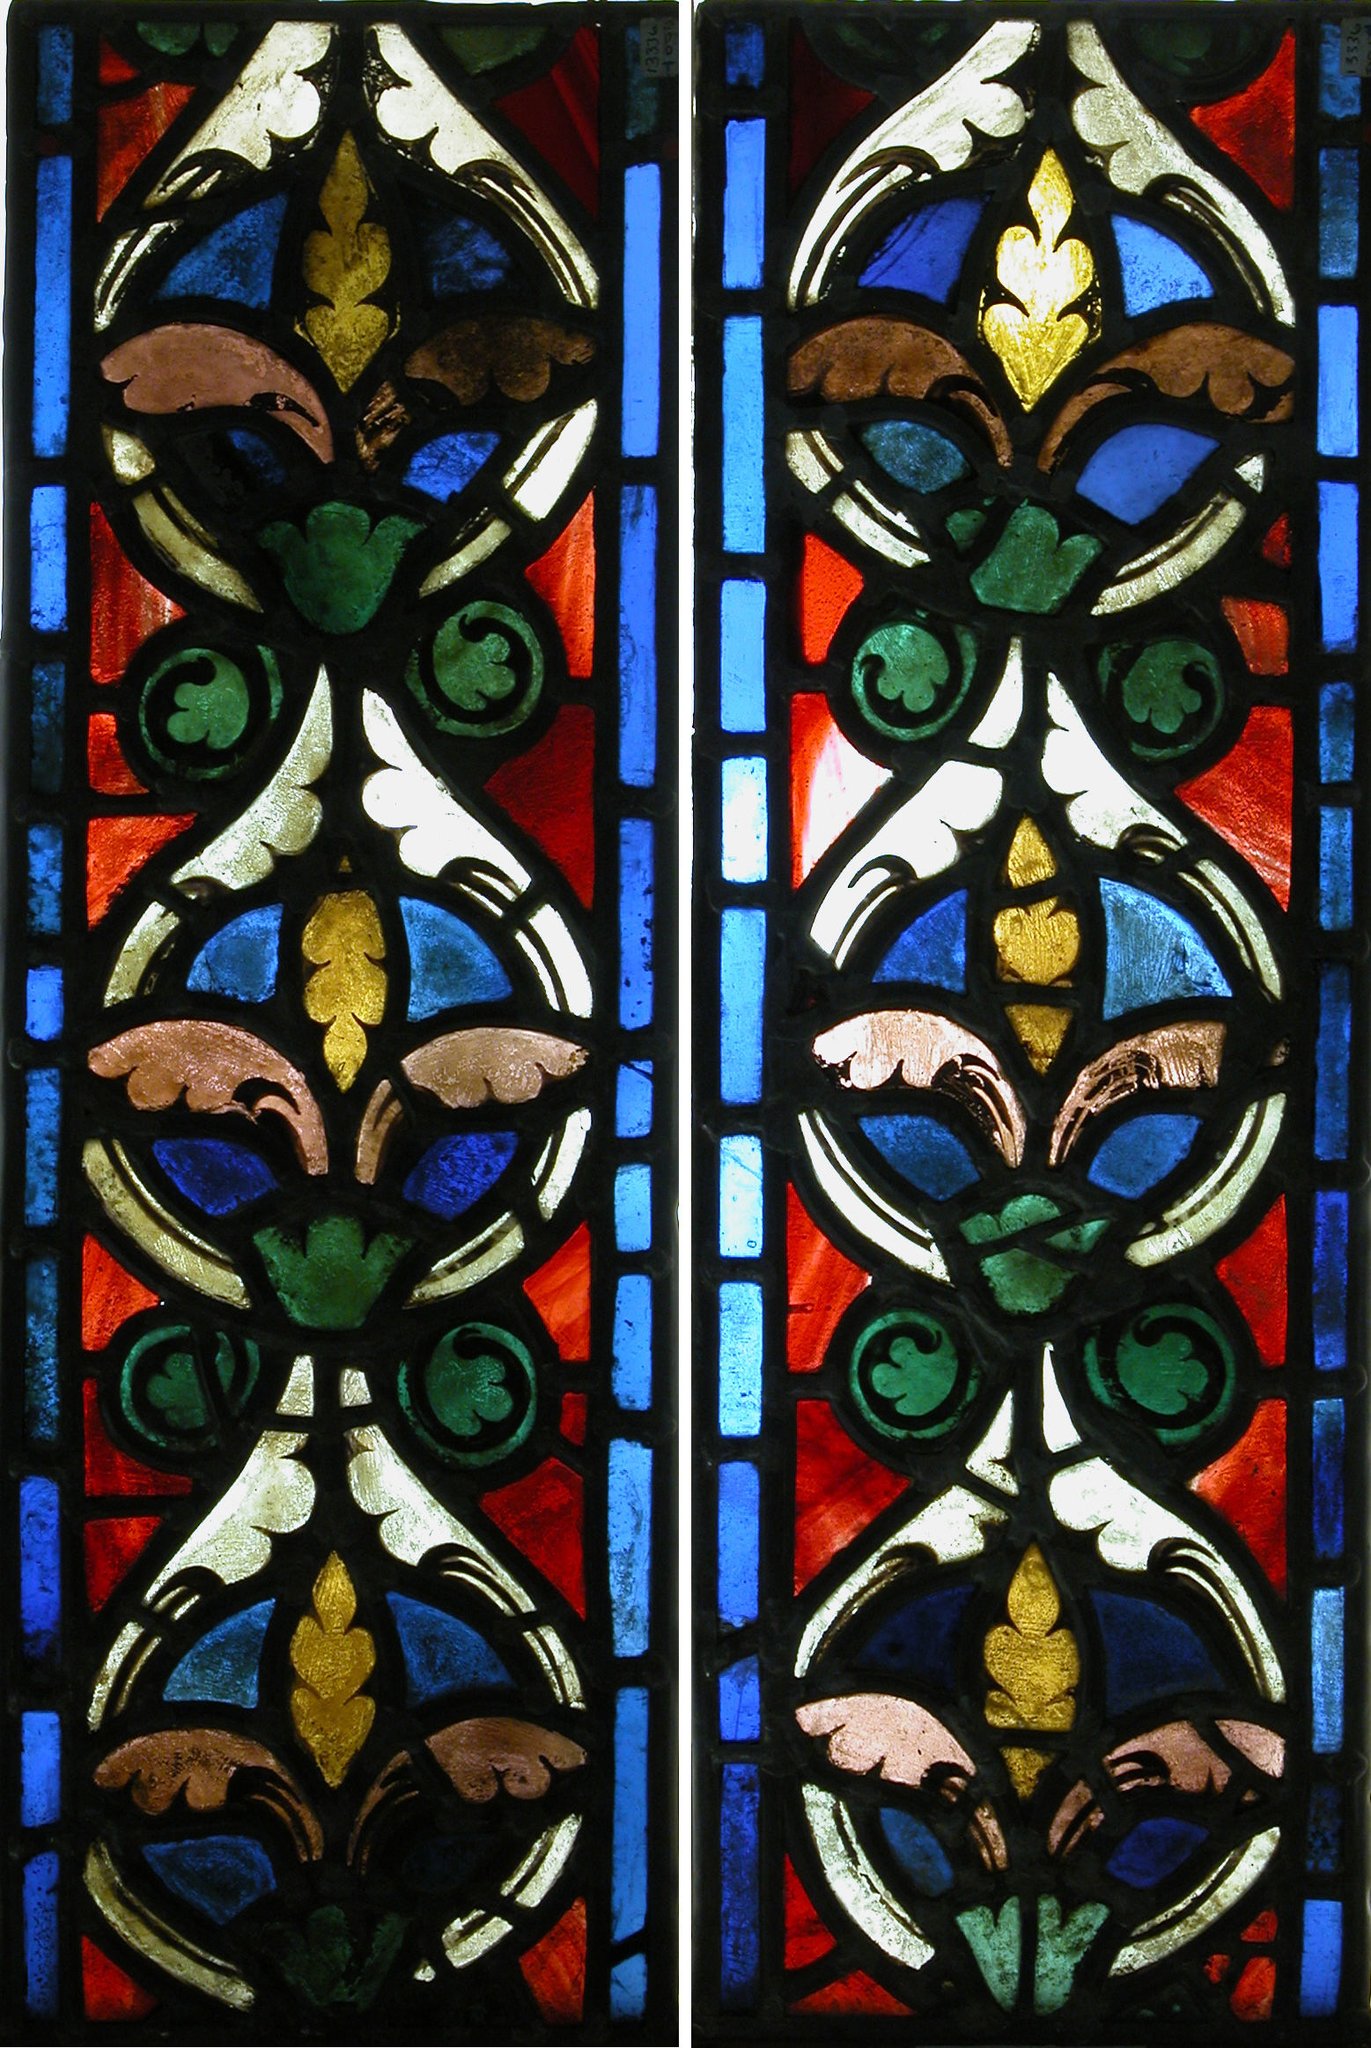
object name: stained glass panel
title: Two Sections of a Border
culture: french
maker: rémois atelier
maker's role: artist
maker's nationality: french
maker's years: 1170-1235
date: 1175-1200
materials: glass, metal, paint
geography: france